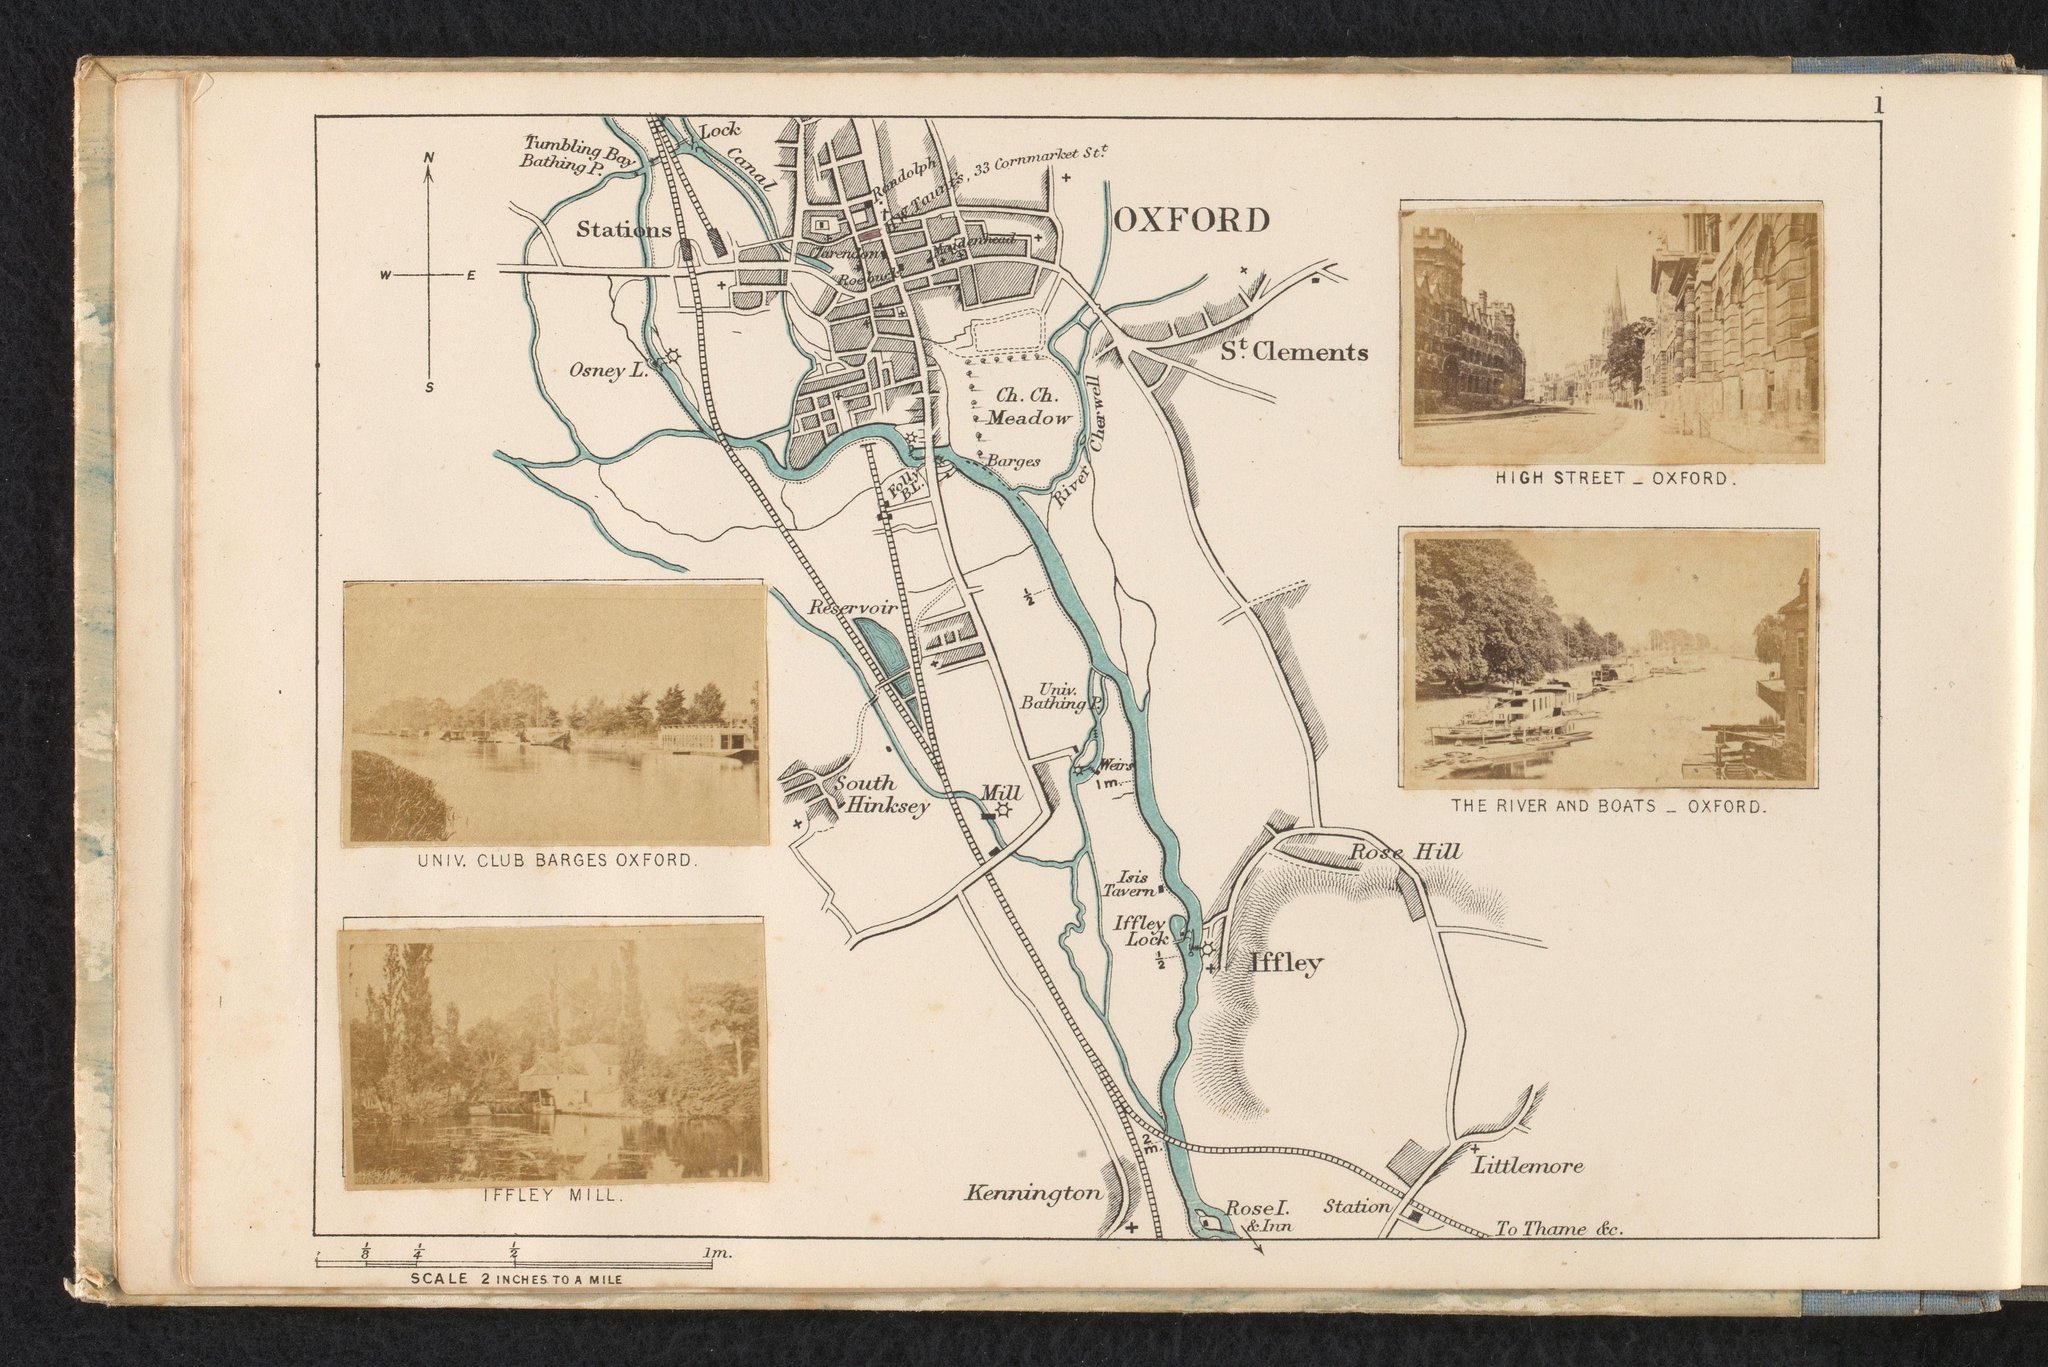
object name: page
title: Gezicht op winkelstraat in Oxford, gezicht op Theems met boten in Oxford, clubboten van de universiteit van Oxford en gezicht op watermolen in Iffley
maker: Anonymous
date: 1868-1873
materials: paper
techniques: albumen print, letterpress printing, line block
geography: oxfordshire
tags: motorized barge, river bank, watermill in landscape, street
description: Foto's op zesde ongenummerde pagina na titelpagina.